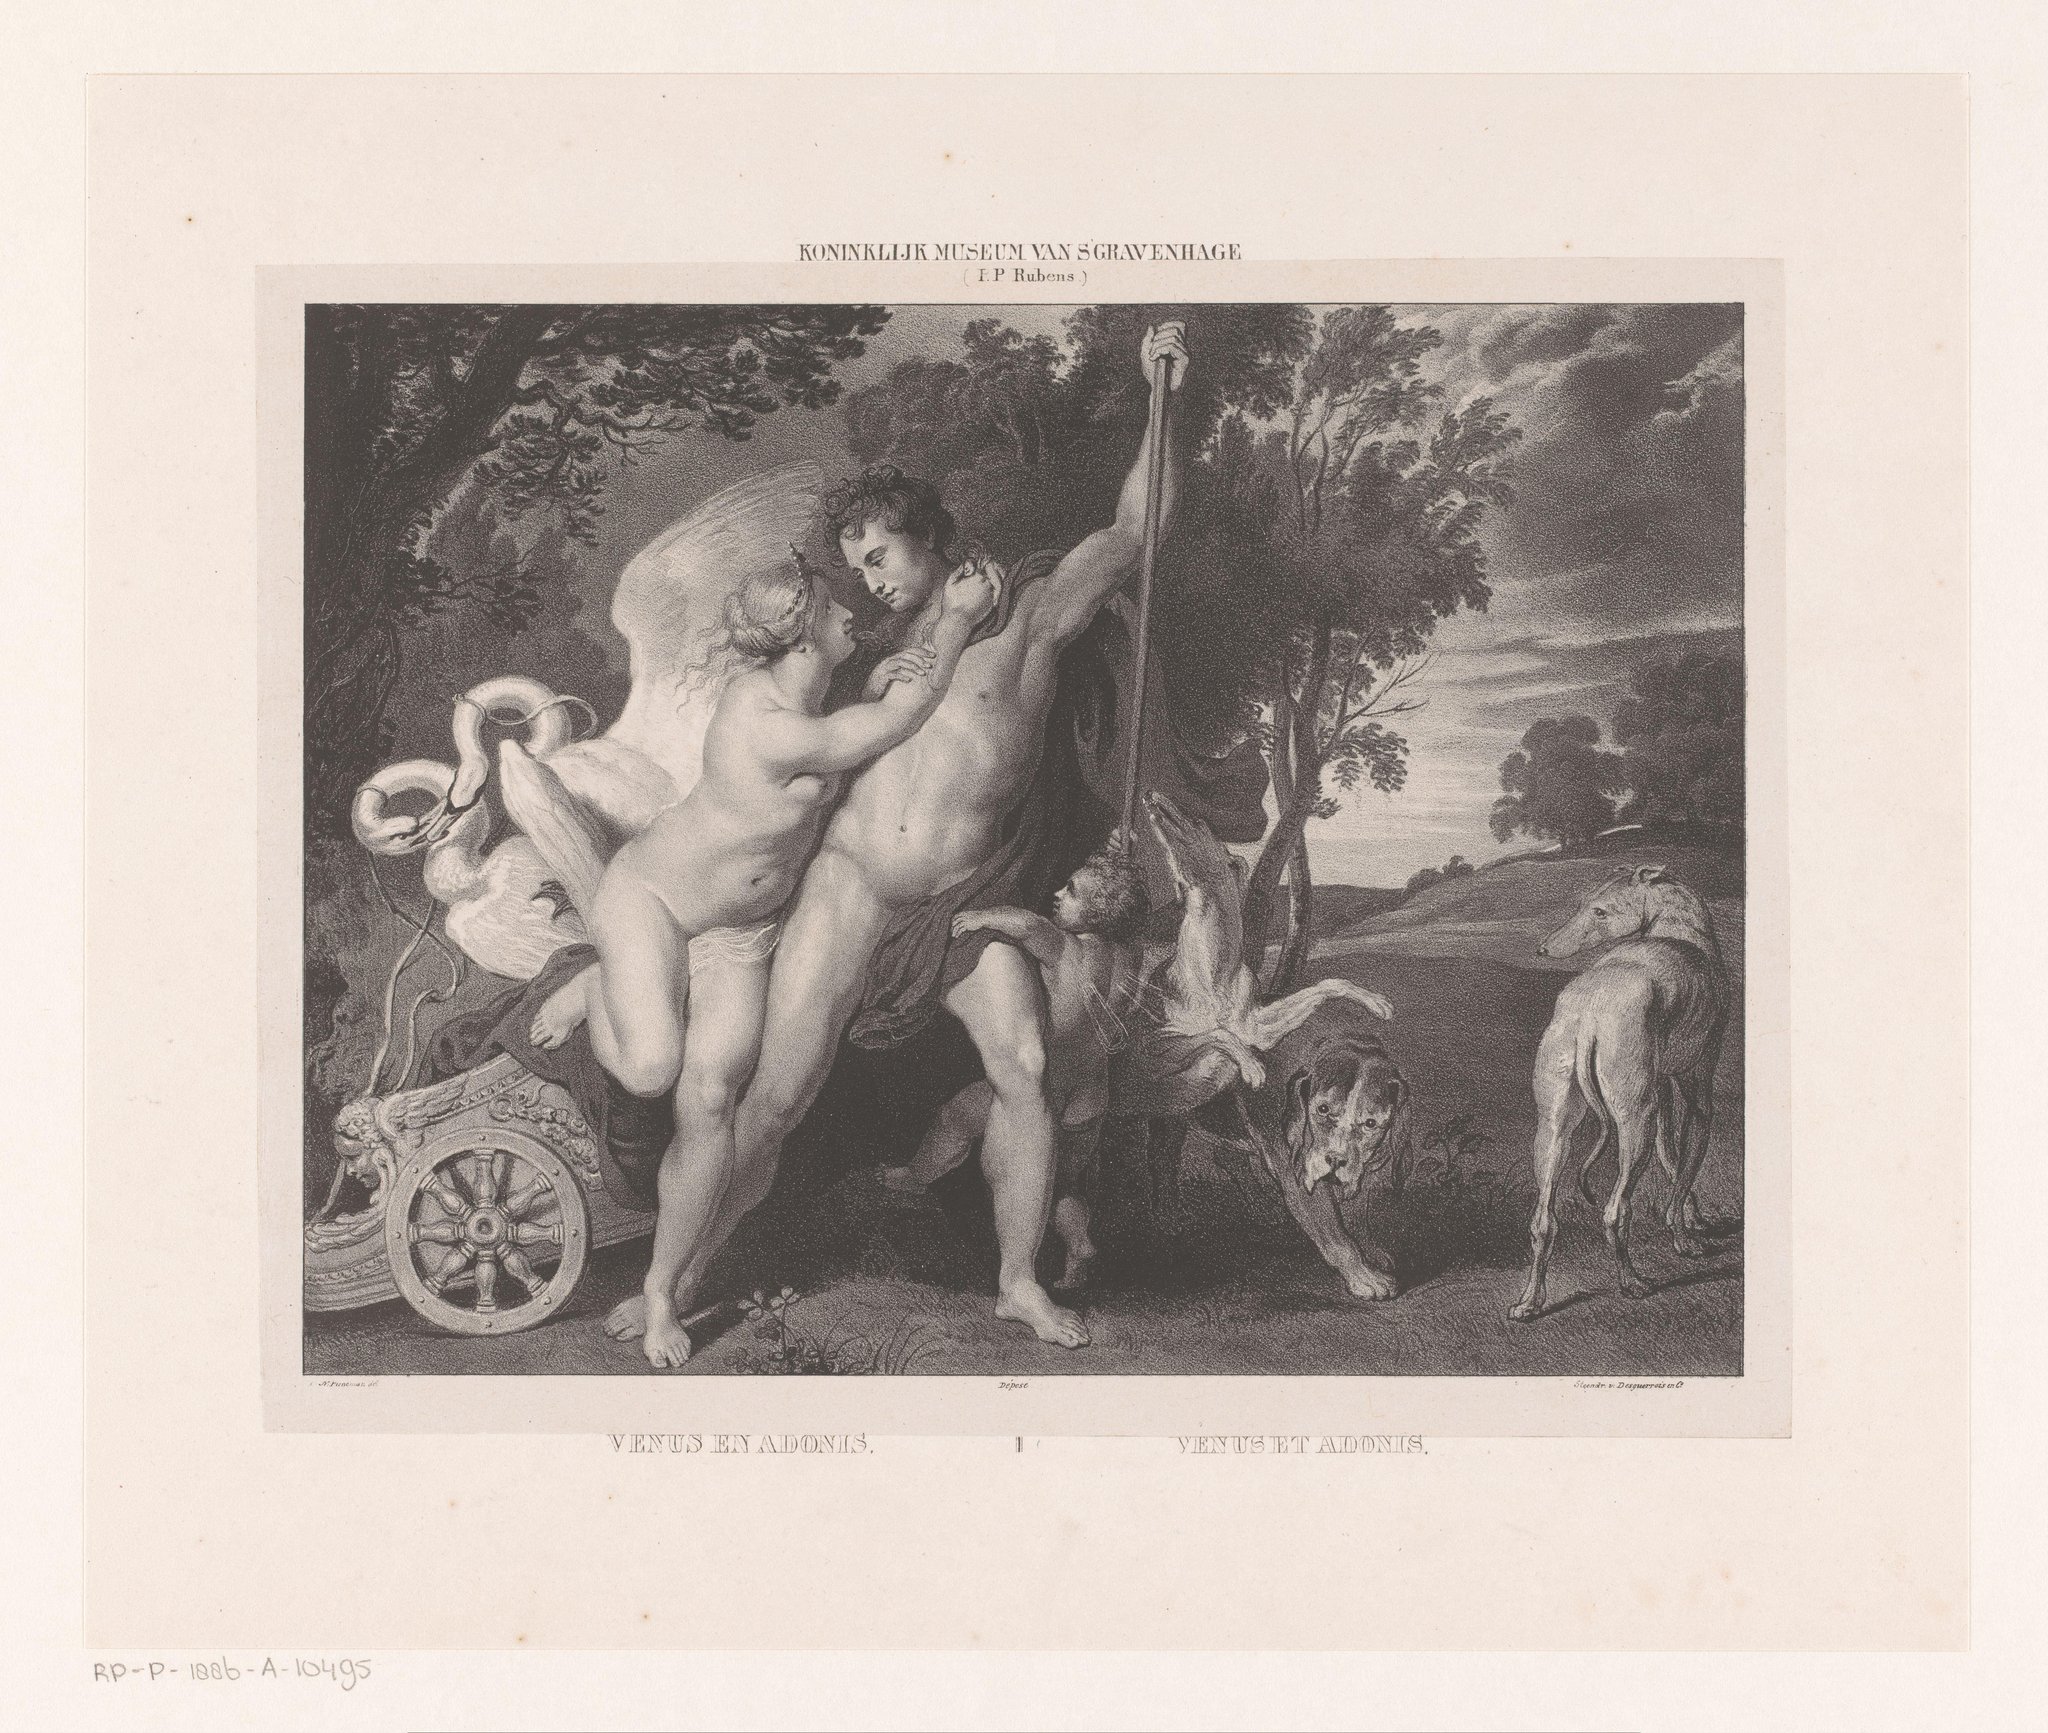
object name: print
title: Koninklijk museum van 's Gravenhage (P.P. Rubens)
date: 1827-1860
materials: paper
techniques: lithograph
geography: amsterdam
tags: venus trying to prevent adonis from going hunting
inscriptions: collector's mark: Lugt 2228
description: Venus probeert Adonis, met speer en jachthonden klaar om te gaan jagen, van de jacht te weerhouden die voor hem dodelijk zal eindigen. Links twee zwanen, rechts drie honden.